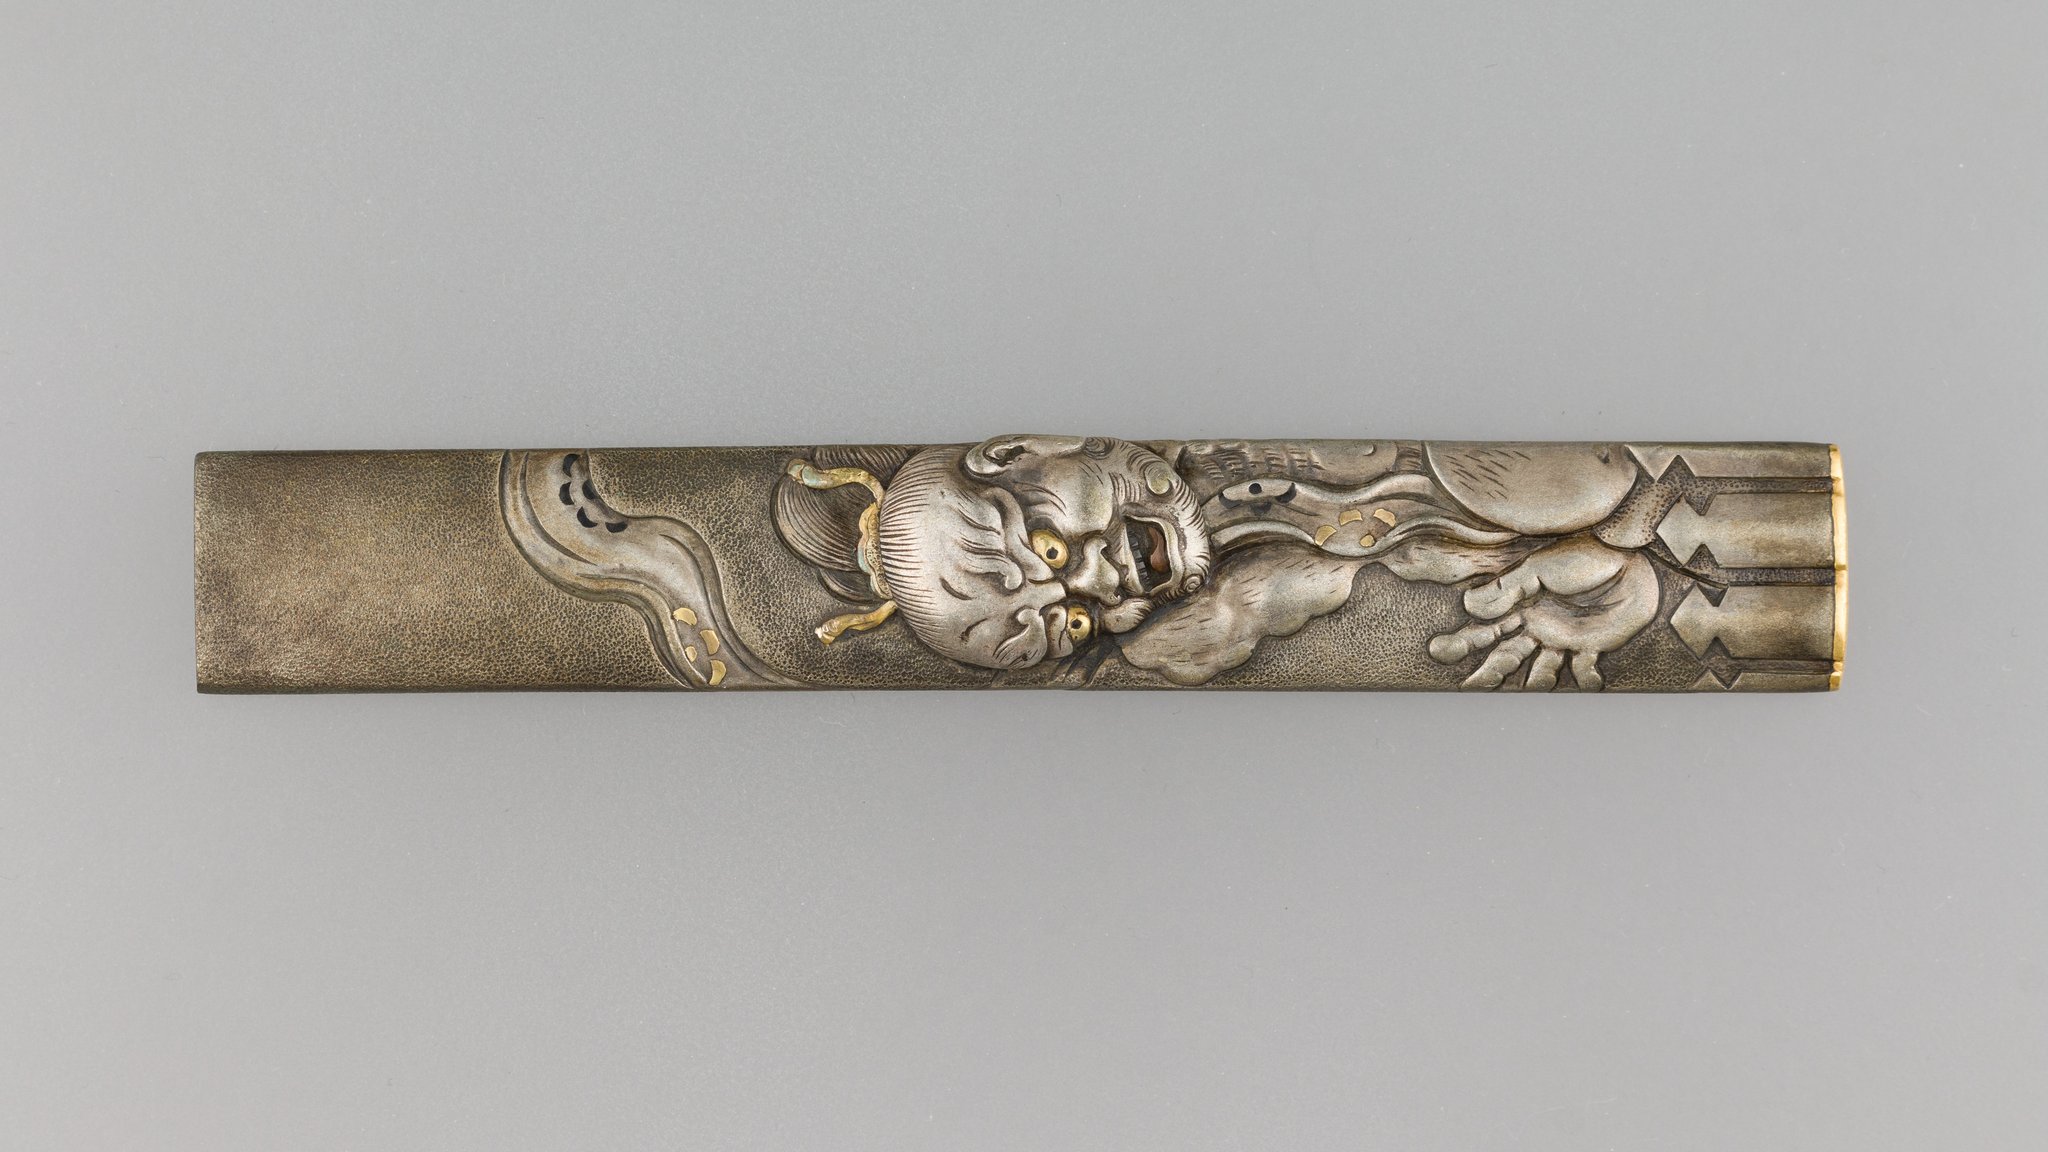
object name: knife handle kozuka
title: Knife Handle (Kozuka)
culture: japanese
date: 1834-1866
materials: silver alloy, gold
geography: japan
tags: men